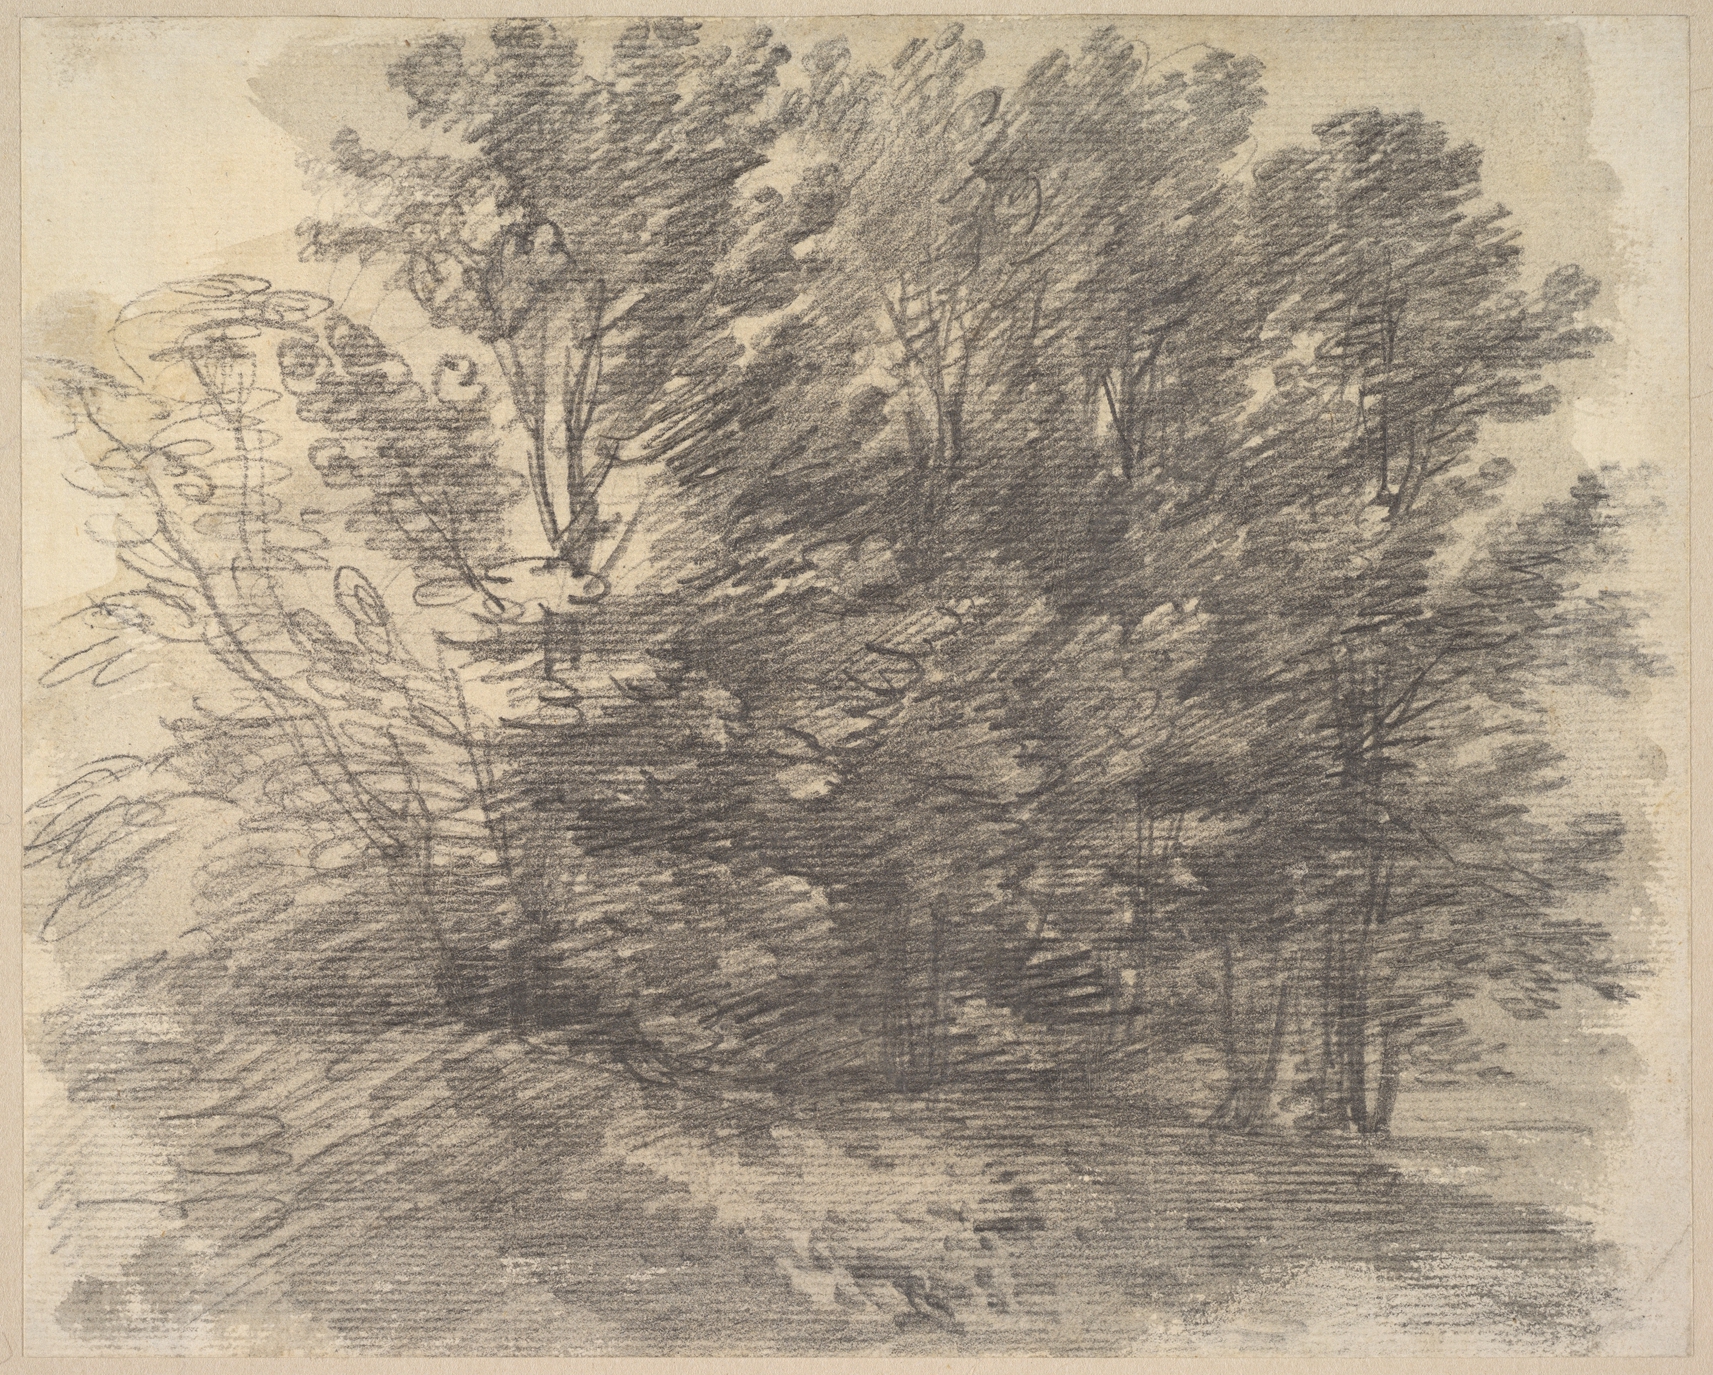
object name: drawing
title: A clump of trees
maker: thomas gainsborough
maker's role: artist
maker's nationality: british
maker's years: 1727-1788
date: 1757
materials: graphite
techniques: brush, wash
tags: trees